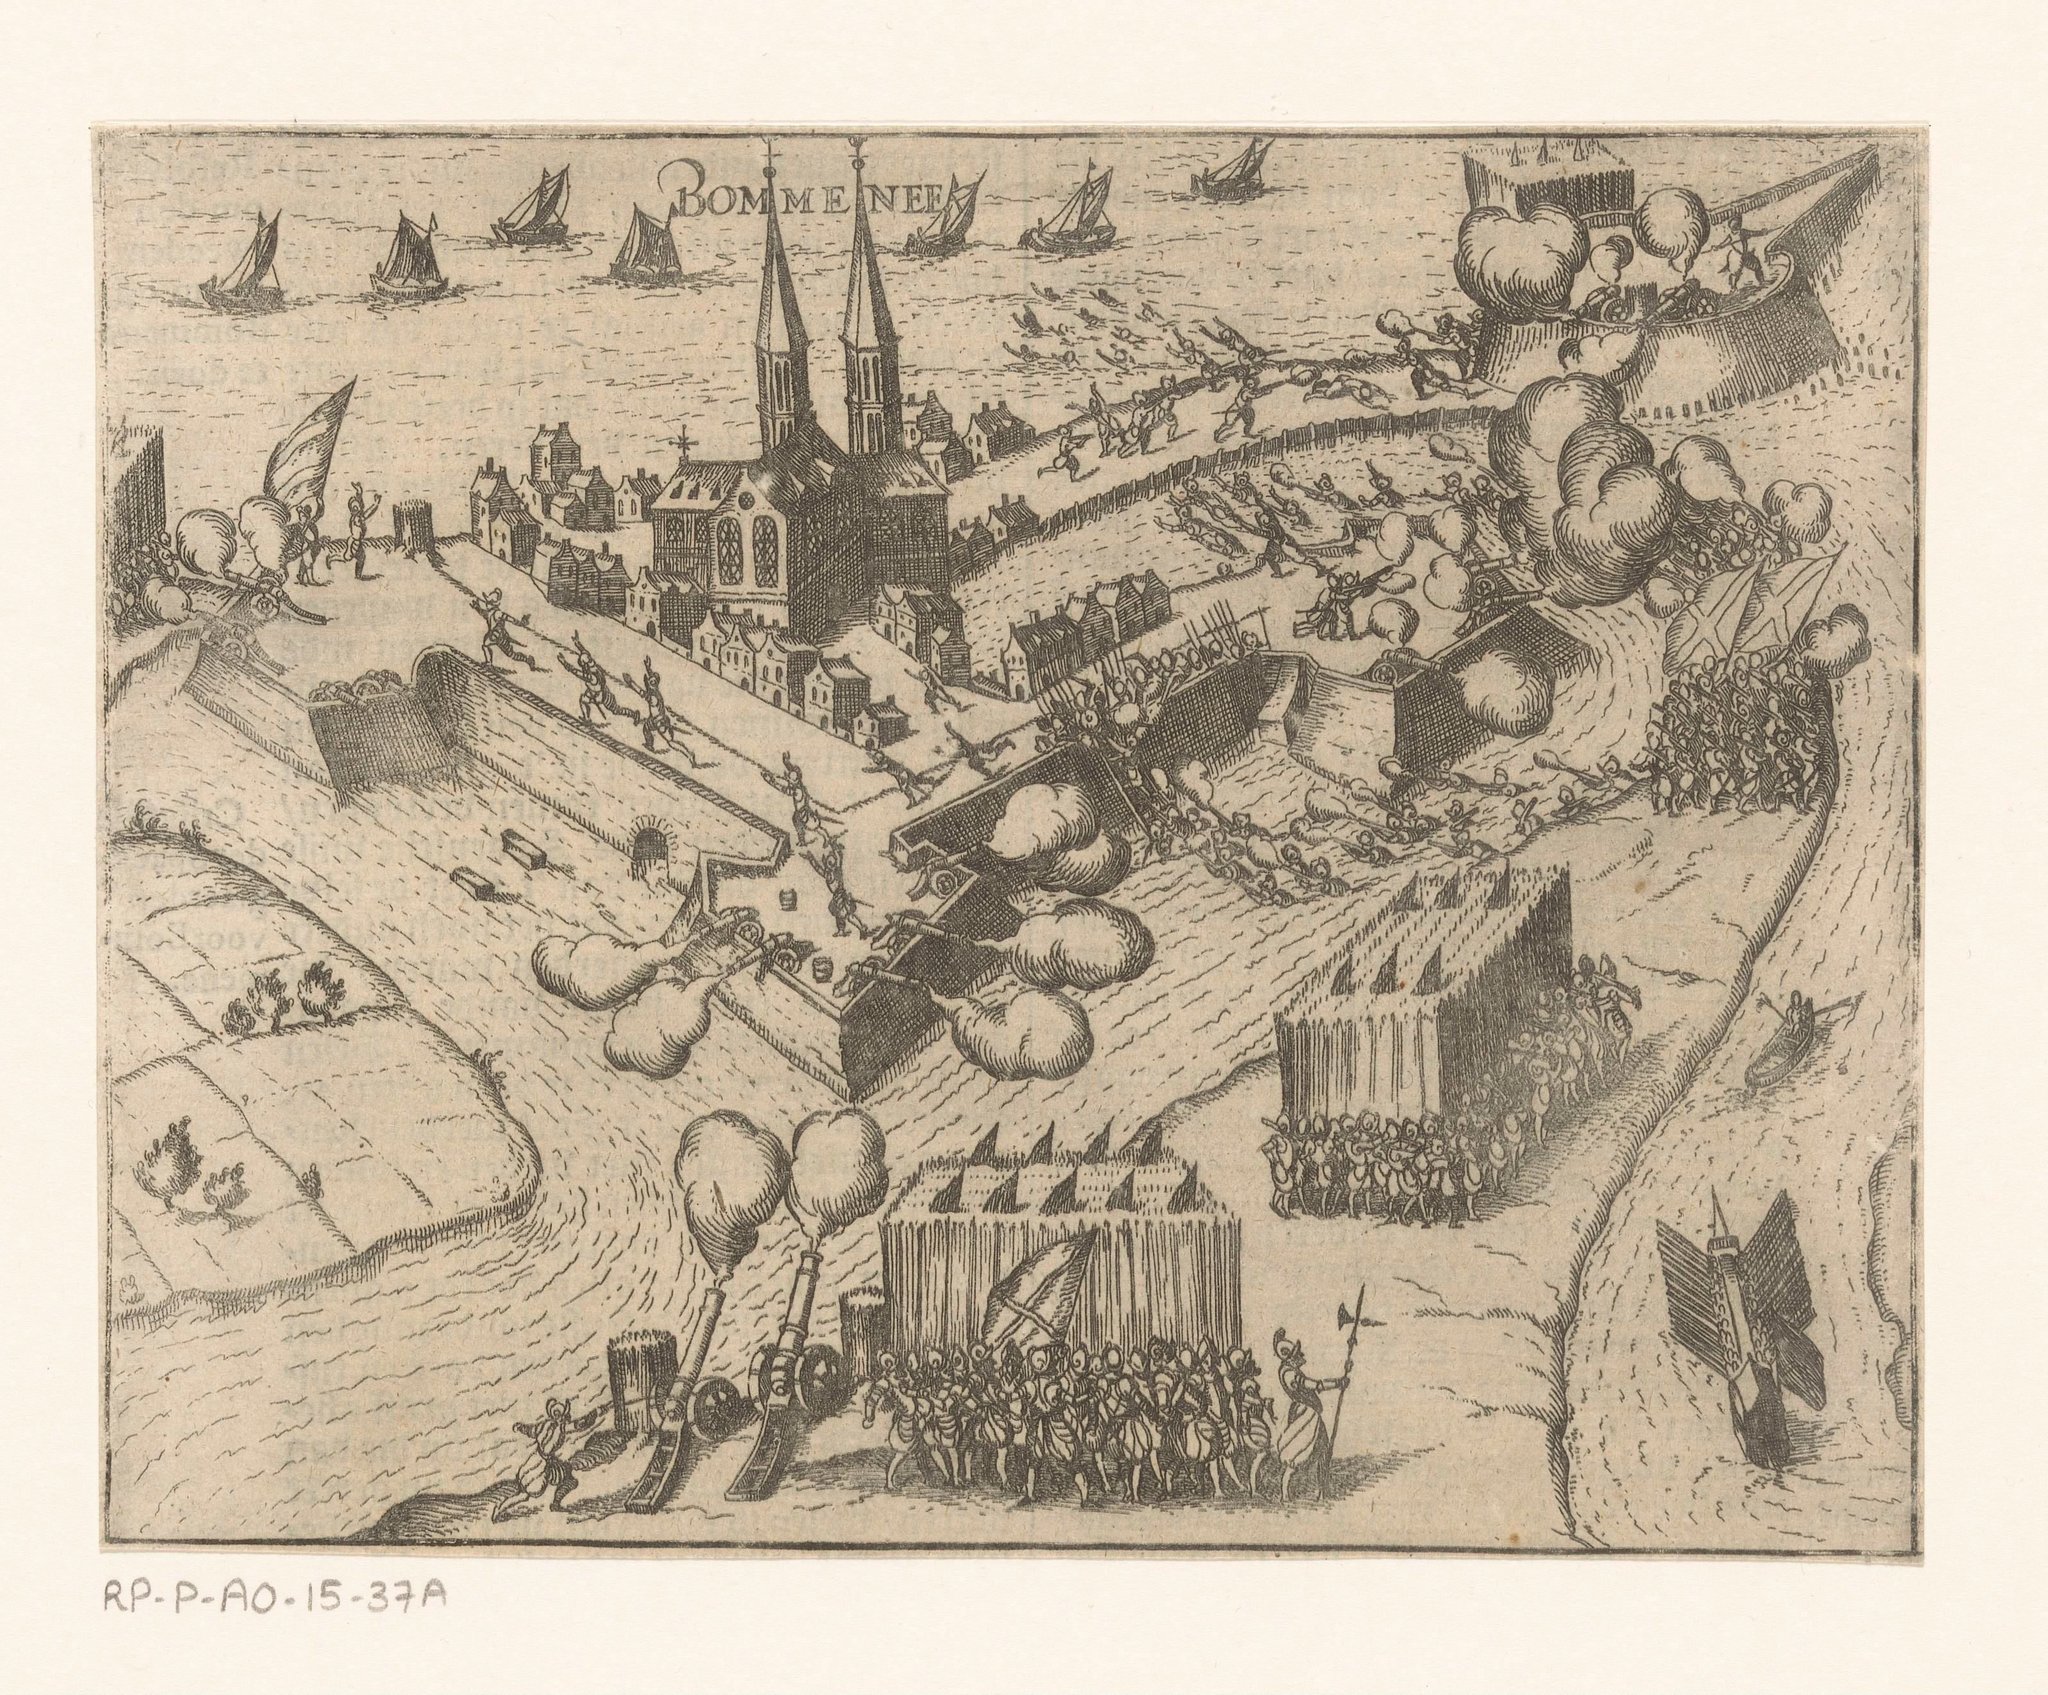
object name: print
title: Bommenede ingenomen door de Spanjaarden, 1575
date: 1621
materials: paper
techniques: etching, letterpress printing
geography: amsterdam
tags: siege, position war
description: Prent gebruikt in: Bor Christiaansz, Pieter. Oorspronck, begin ende vervolgh der Nederlantsche Oorlogen (…) / Nederlantsche Oorloghen, beroerten, ende borgelijcke oneenicheyden (…). 5 delen. Amsterdam: Michiel Colijn, Leiden: Govert Basson, 1621-1634, dl. 1 (1621), p. 126. Prent eerder ook gebruikt in: Baudartius, Willem. De Nassavsche oorloghen / Afbeeldinghe, ende beschrijvinghe van alle de veld-slagen, belegeringen en ghevallen in de Nederlanden (…). Amsterdam: Michiel Colijn, 1615. Zie ook RP-P-OB-79.638.